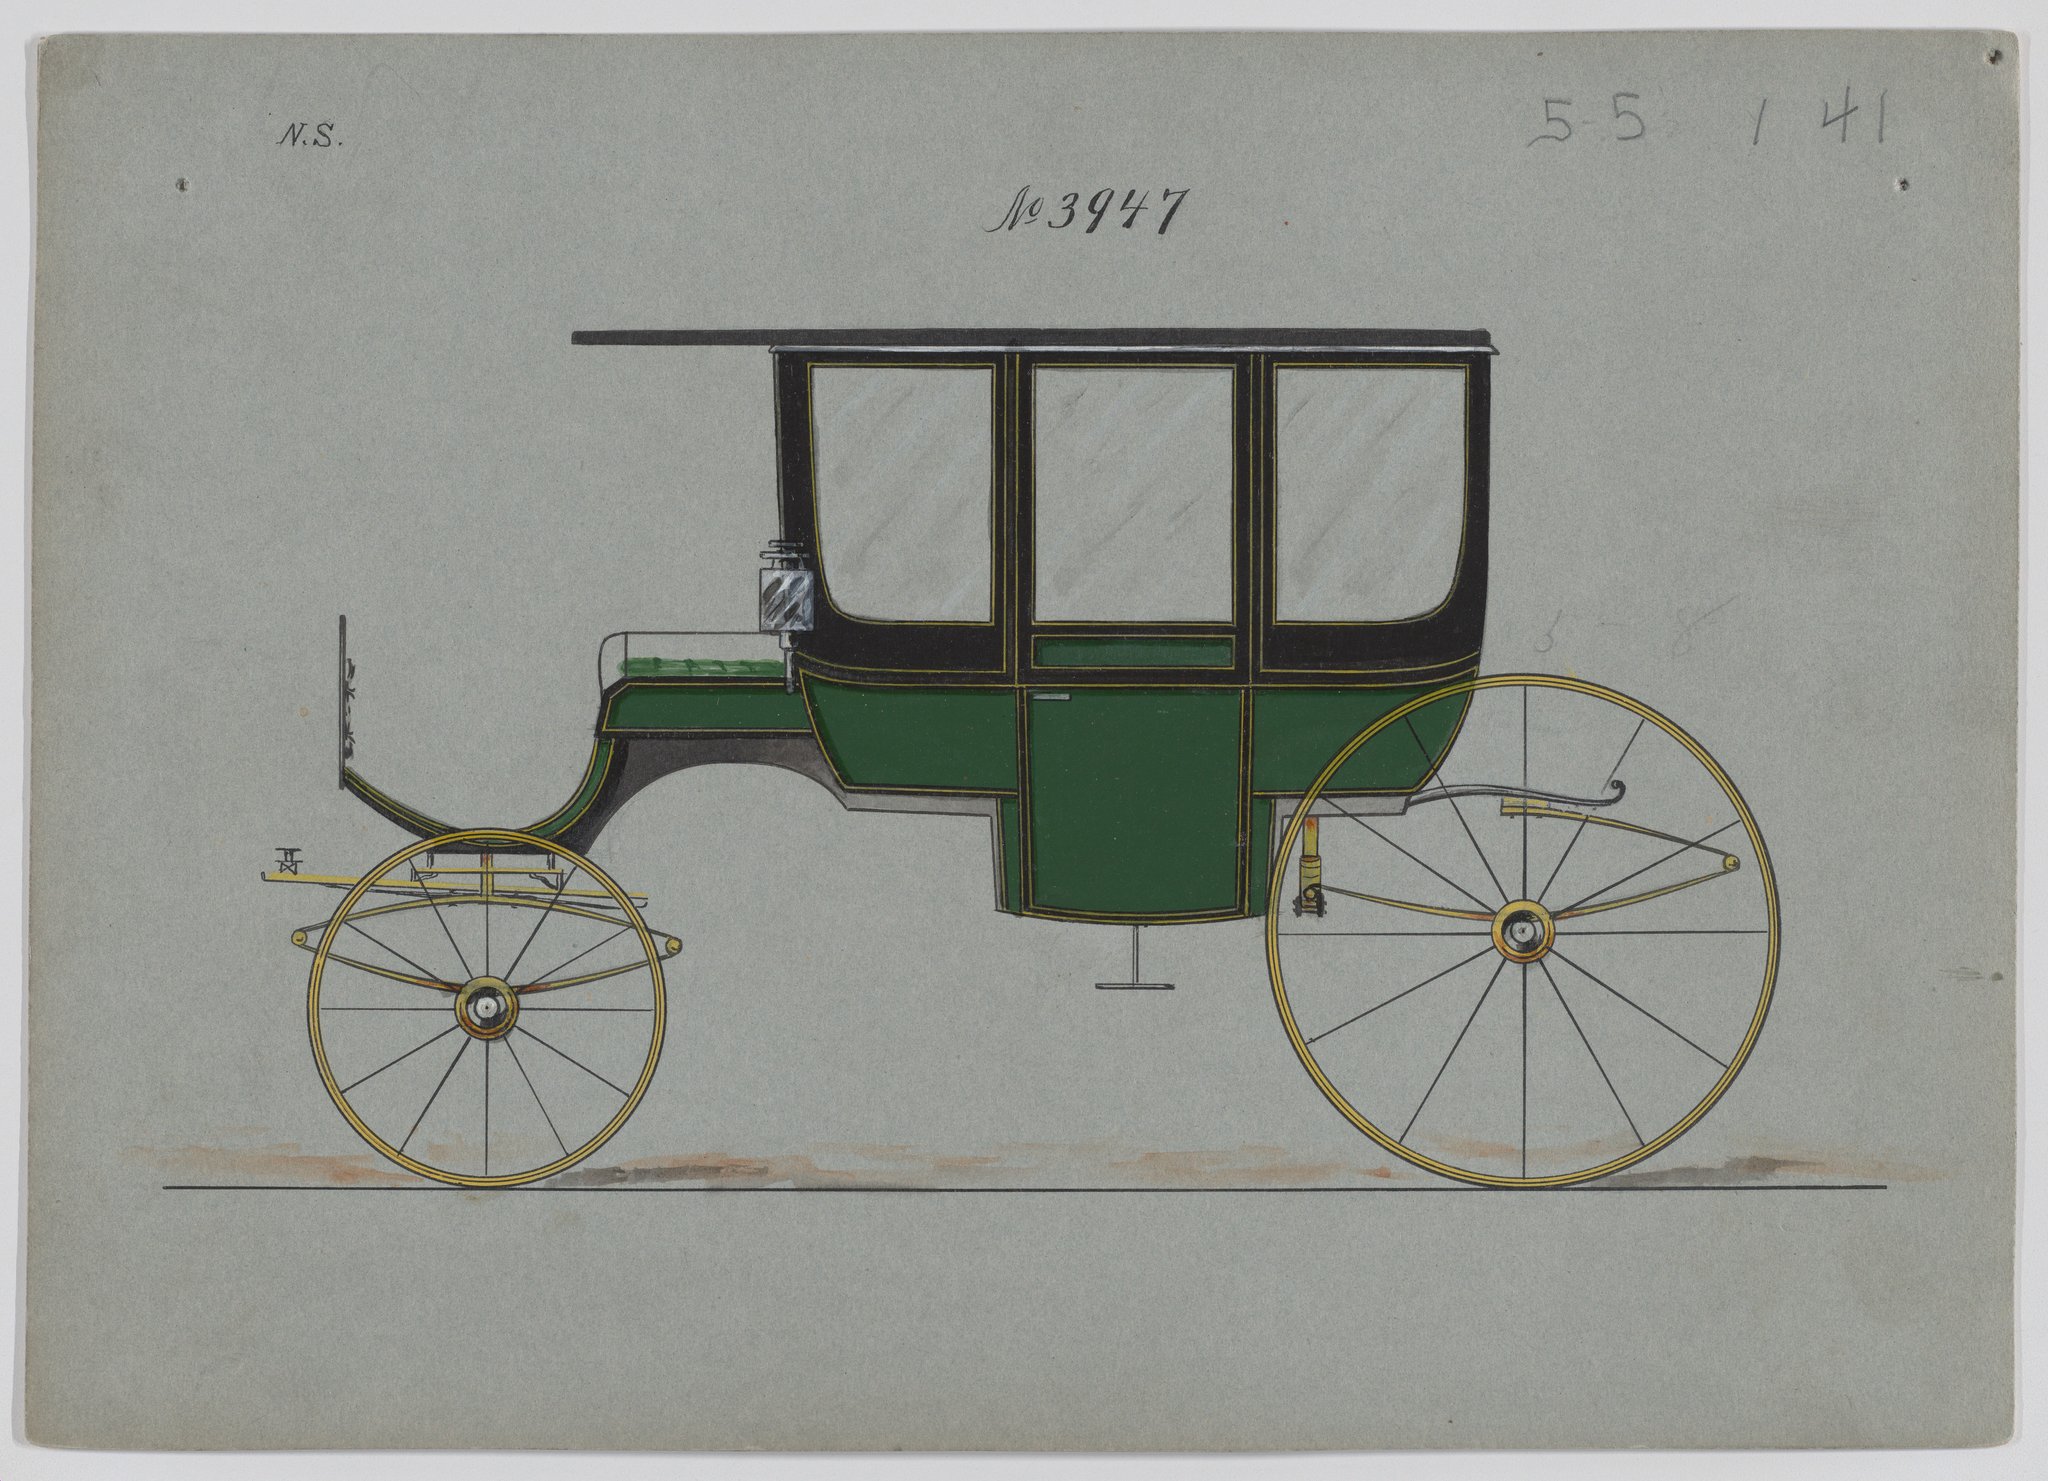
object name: drawing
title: Design for 6 seat Rockaway, no. 3947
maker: brewster & co.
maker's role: manufacturer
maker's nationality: american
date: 1885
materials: gouache, gum arabic, ink, watercolor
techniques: pen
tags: carriages